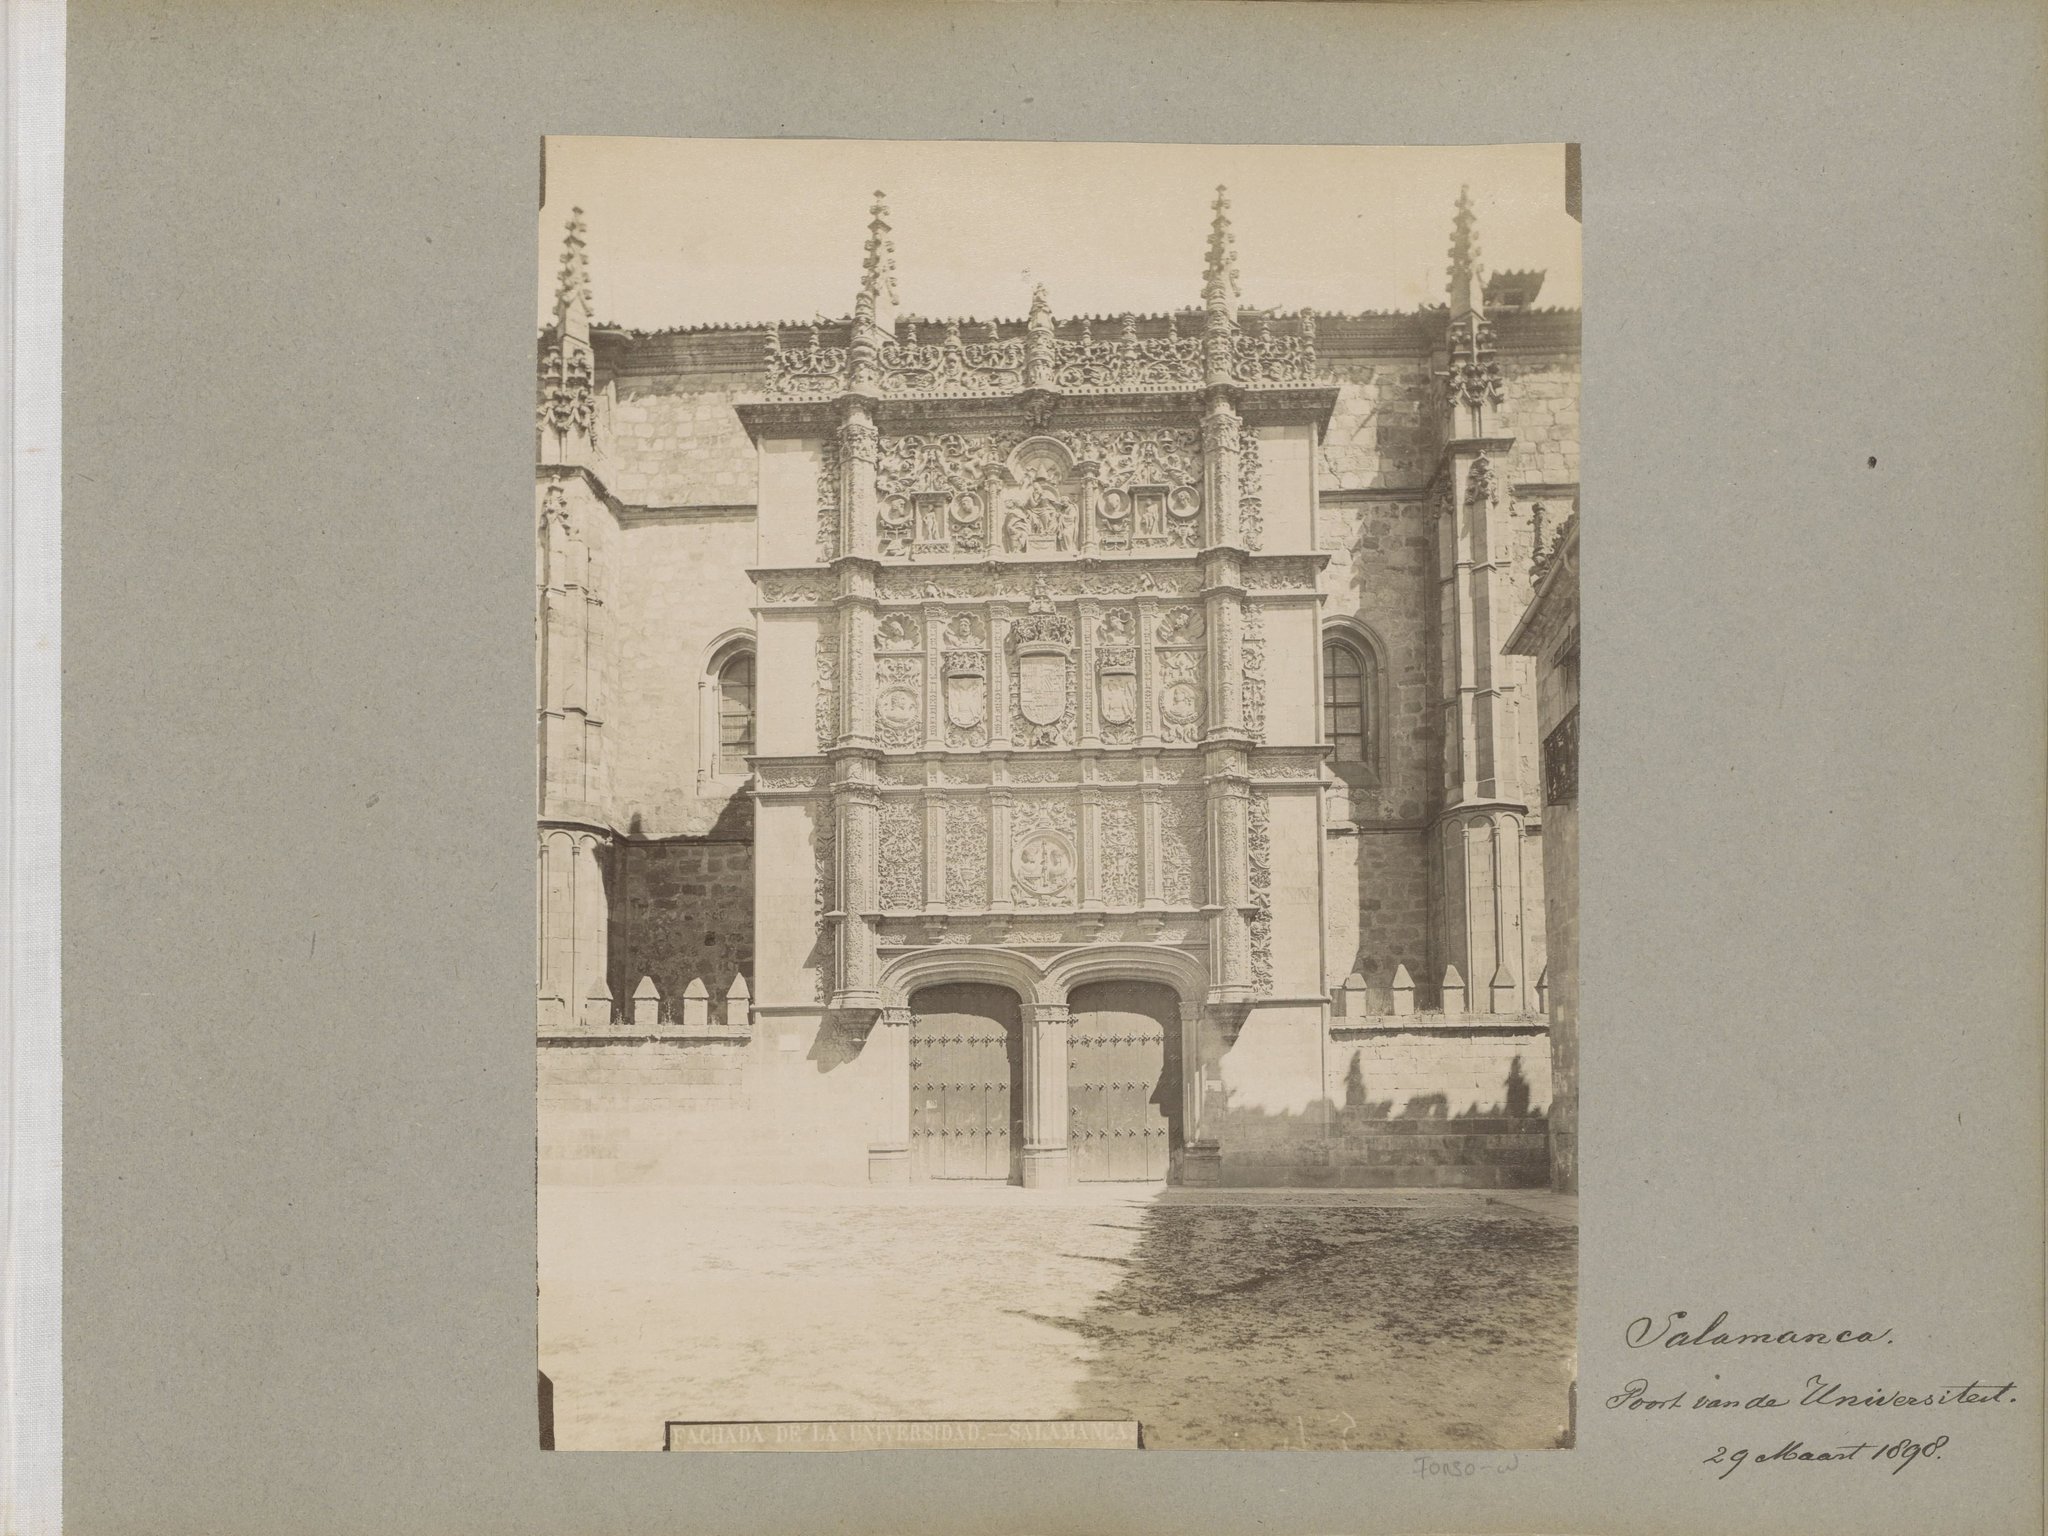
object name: album leaf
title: Gevel van het universiteitsgebouw van Salamanca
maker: Anonymous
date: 1880-1898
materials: paper, photographic support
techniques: albumen print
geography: salamanca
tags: university building, college, façade (of house or building)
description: Onderdeel van Reisalbum met foto's van bezienswaardigheden in Frankrijk, Spanje, Italië, Duitsland, Zwitserland en Oostenrijk.